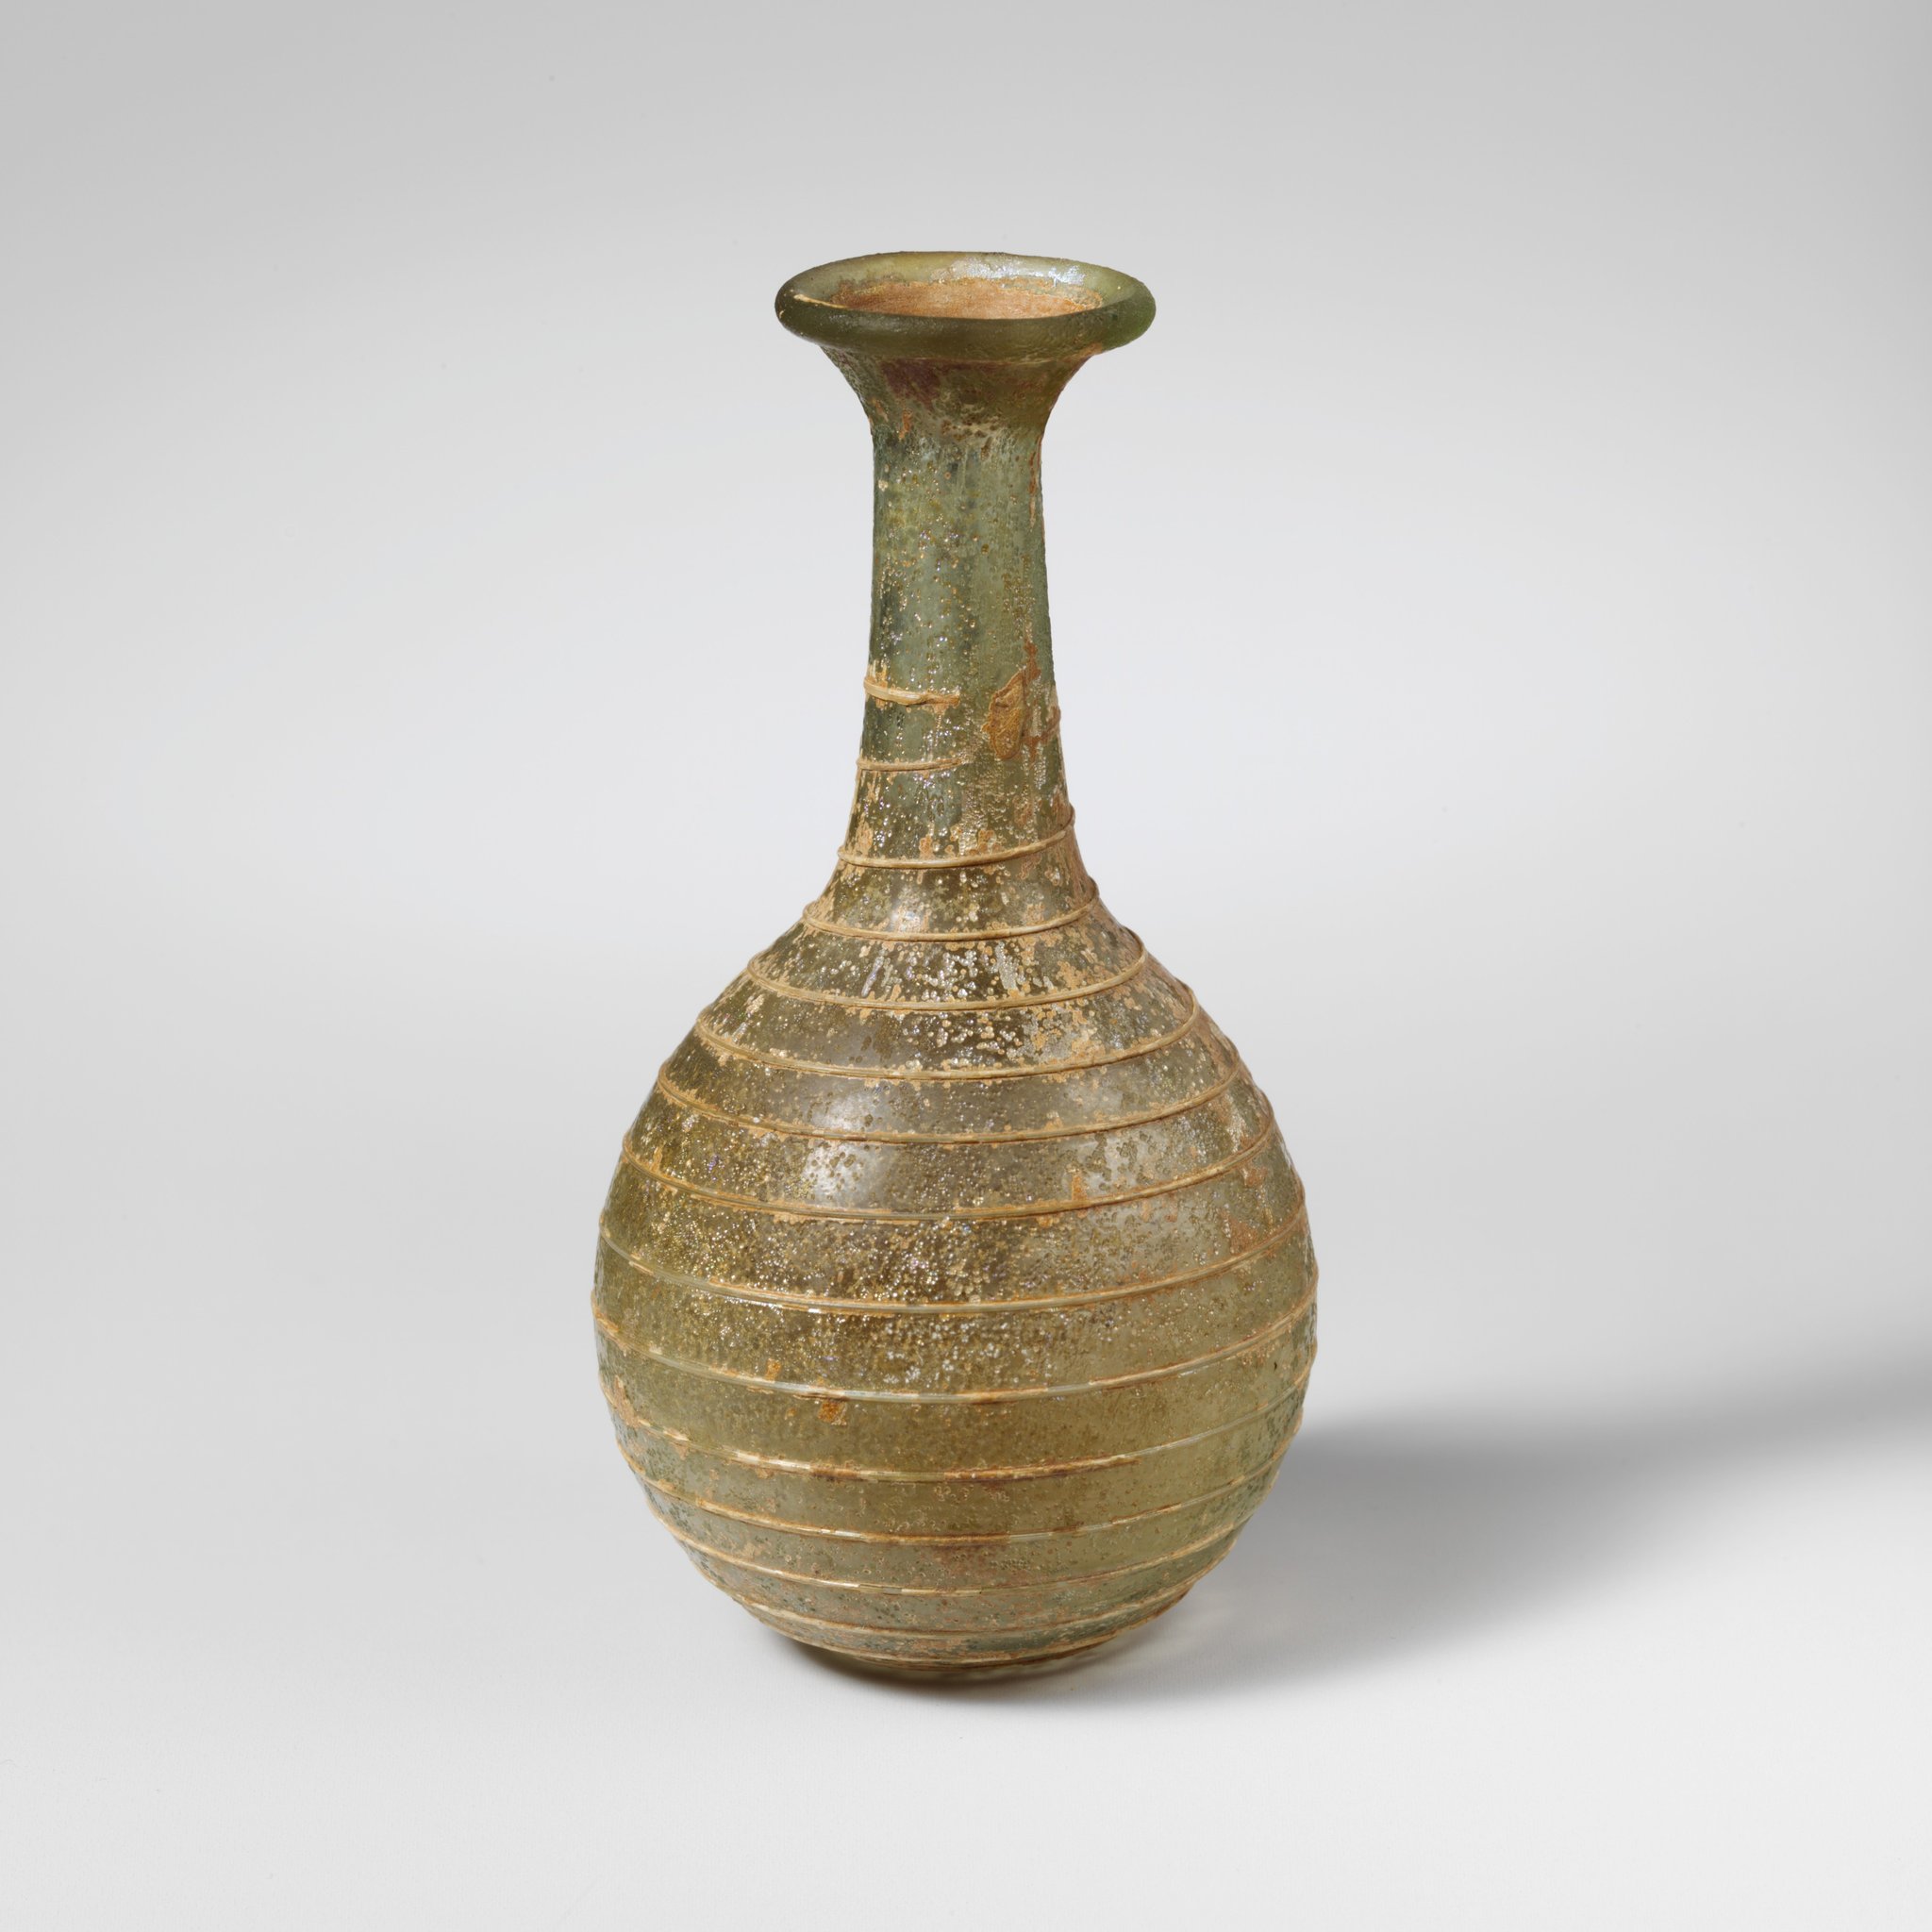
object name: perfume bottle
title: Glass perfume bottle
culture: roman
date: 1-100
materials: glass